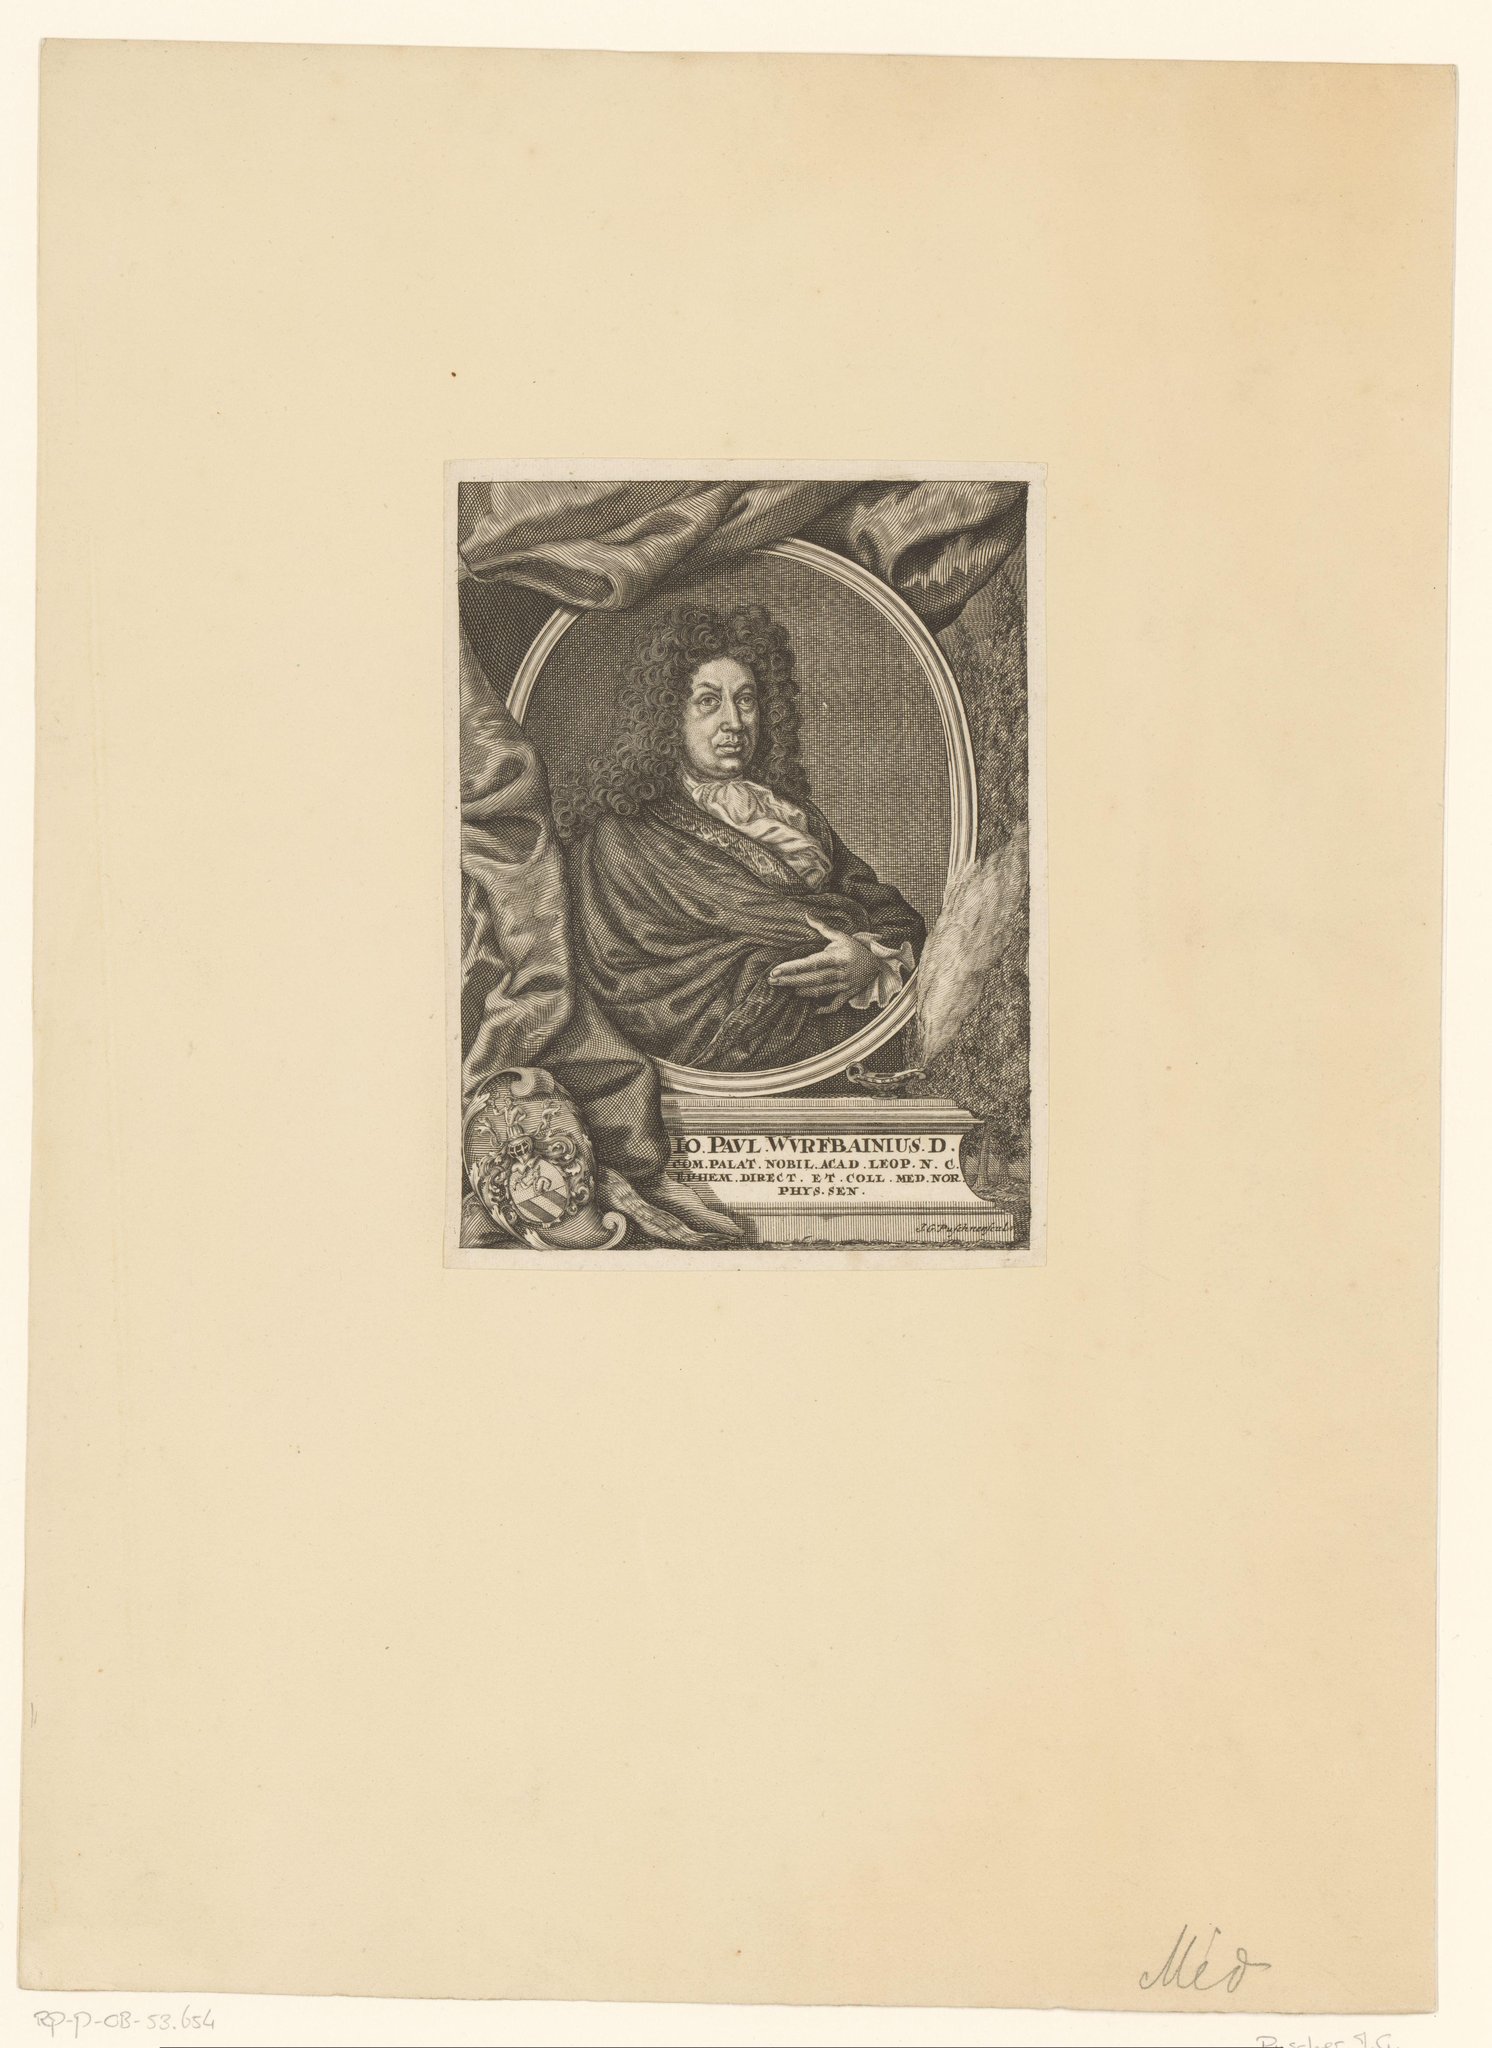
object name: print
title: Portret van Johann Paul Wurfbain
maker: johann georg puschner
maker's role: draughtsman, painter, print maker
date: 1705-1750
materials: paper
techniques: engraving, etching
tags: trees: cypress, historical persons, oil-lamp, armorial bearing, heraldry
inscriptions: collector's mark: Lugt 2228